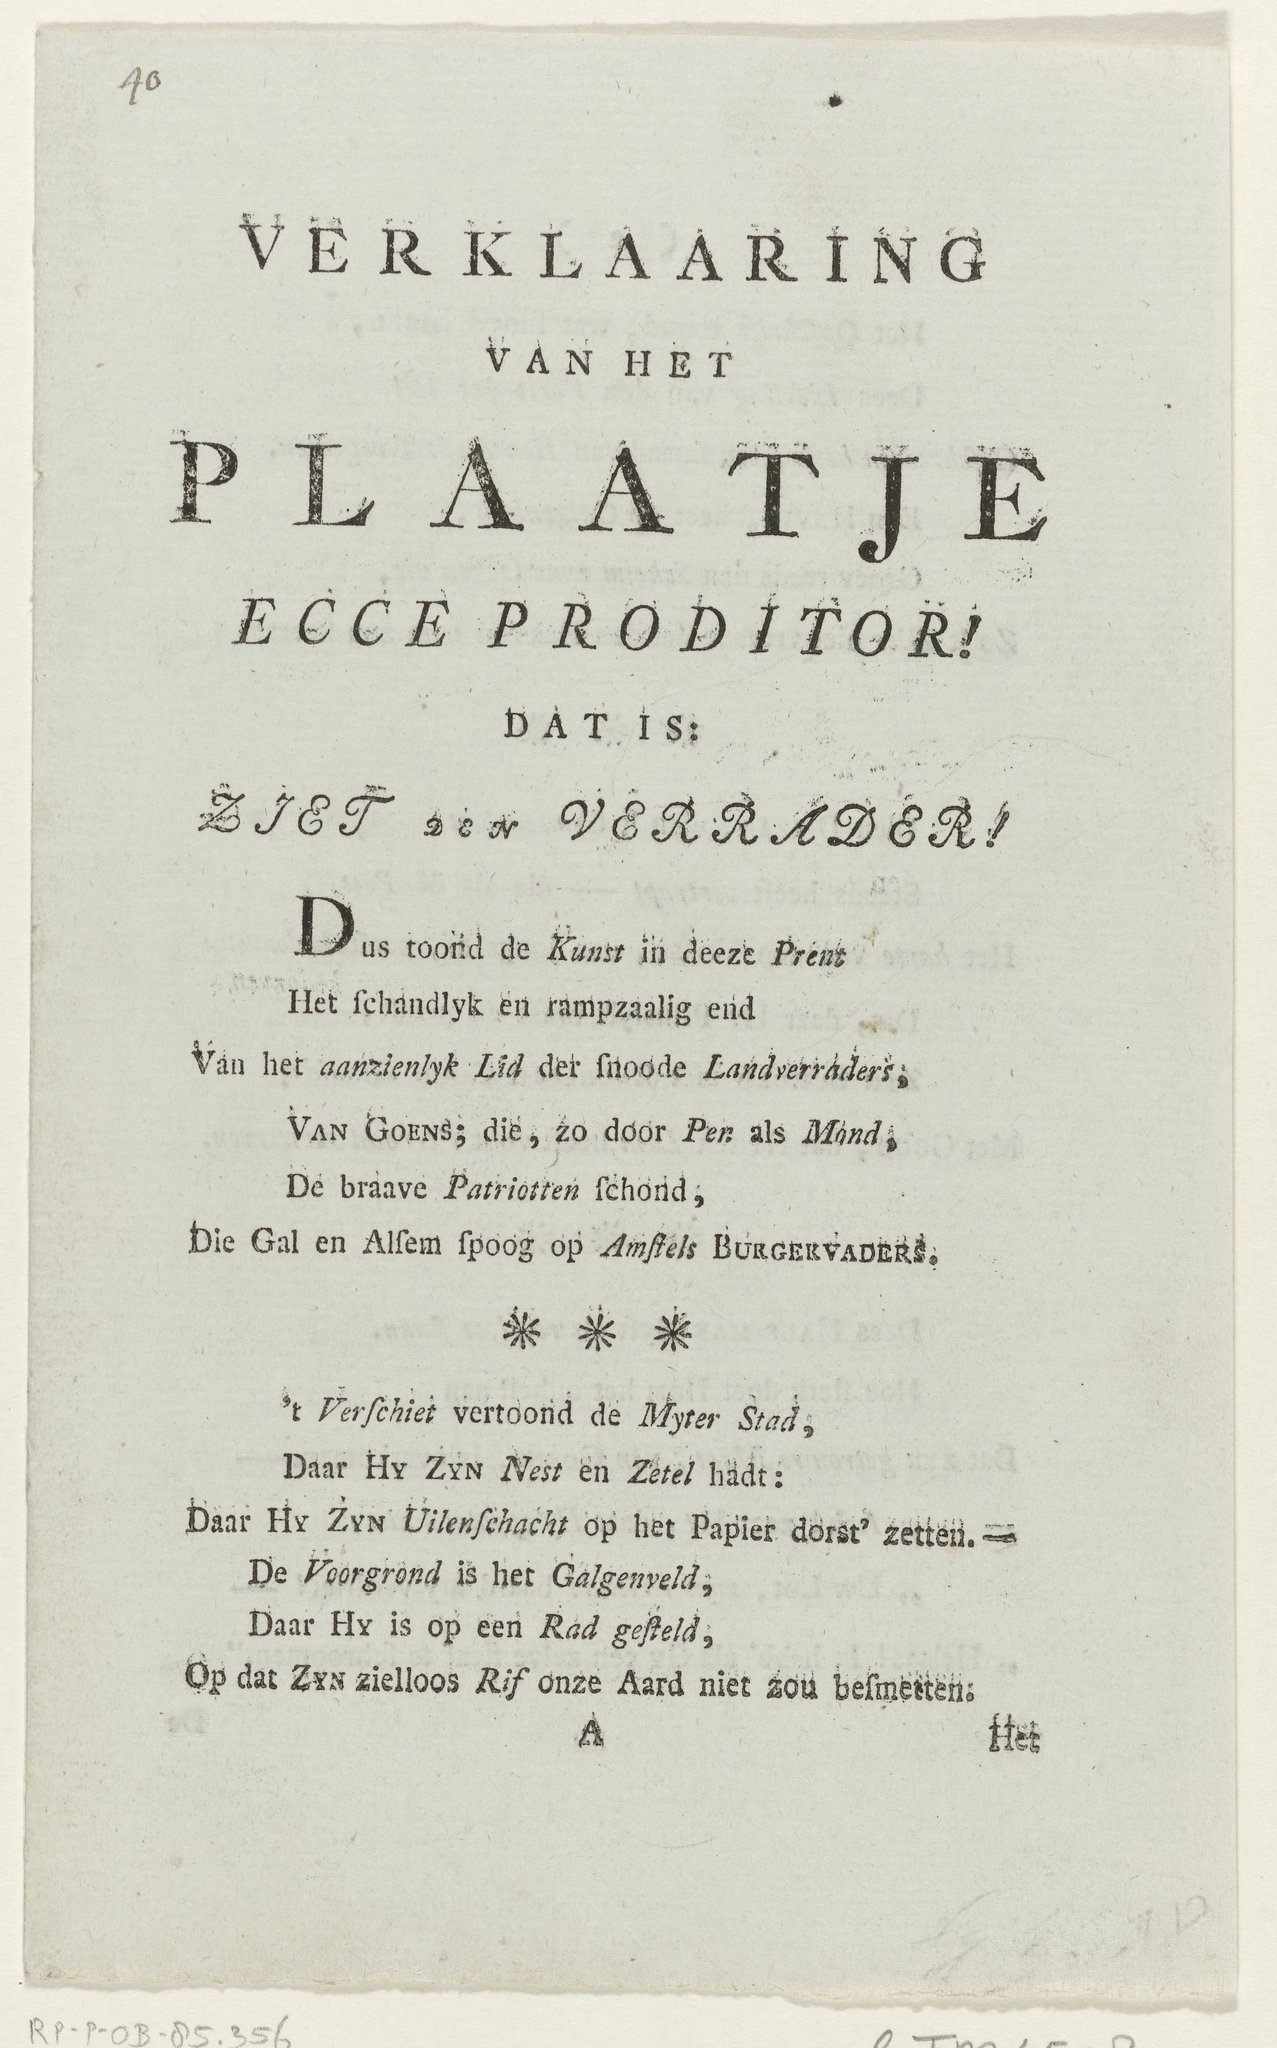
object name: text sheet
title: Verklaaring van het Plaatje Ecce Proditor! Dat is: Ziet den Verrader!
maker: Anonymous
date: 1784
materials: paper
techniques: letterpress printing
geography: northern netherlands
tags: the hague, william v (prince of orange), ludwig ernst von braunschweig-wolfenbüttel, utrecht, patriots (1780-1795)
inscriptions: collector's mark: Lugt 2228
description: Tekstblad met een verklaring van de spotprent op de orangist Rijklof Michael van Goens, veroordeeld als landverrader op het rad, 1784. Dubbelgevouwen blad met een spotvers in negen coupletten op vier bladzijden.